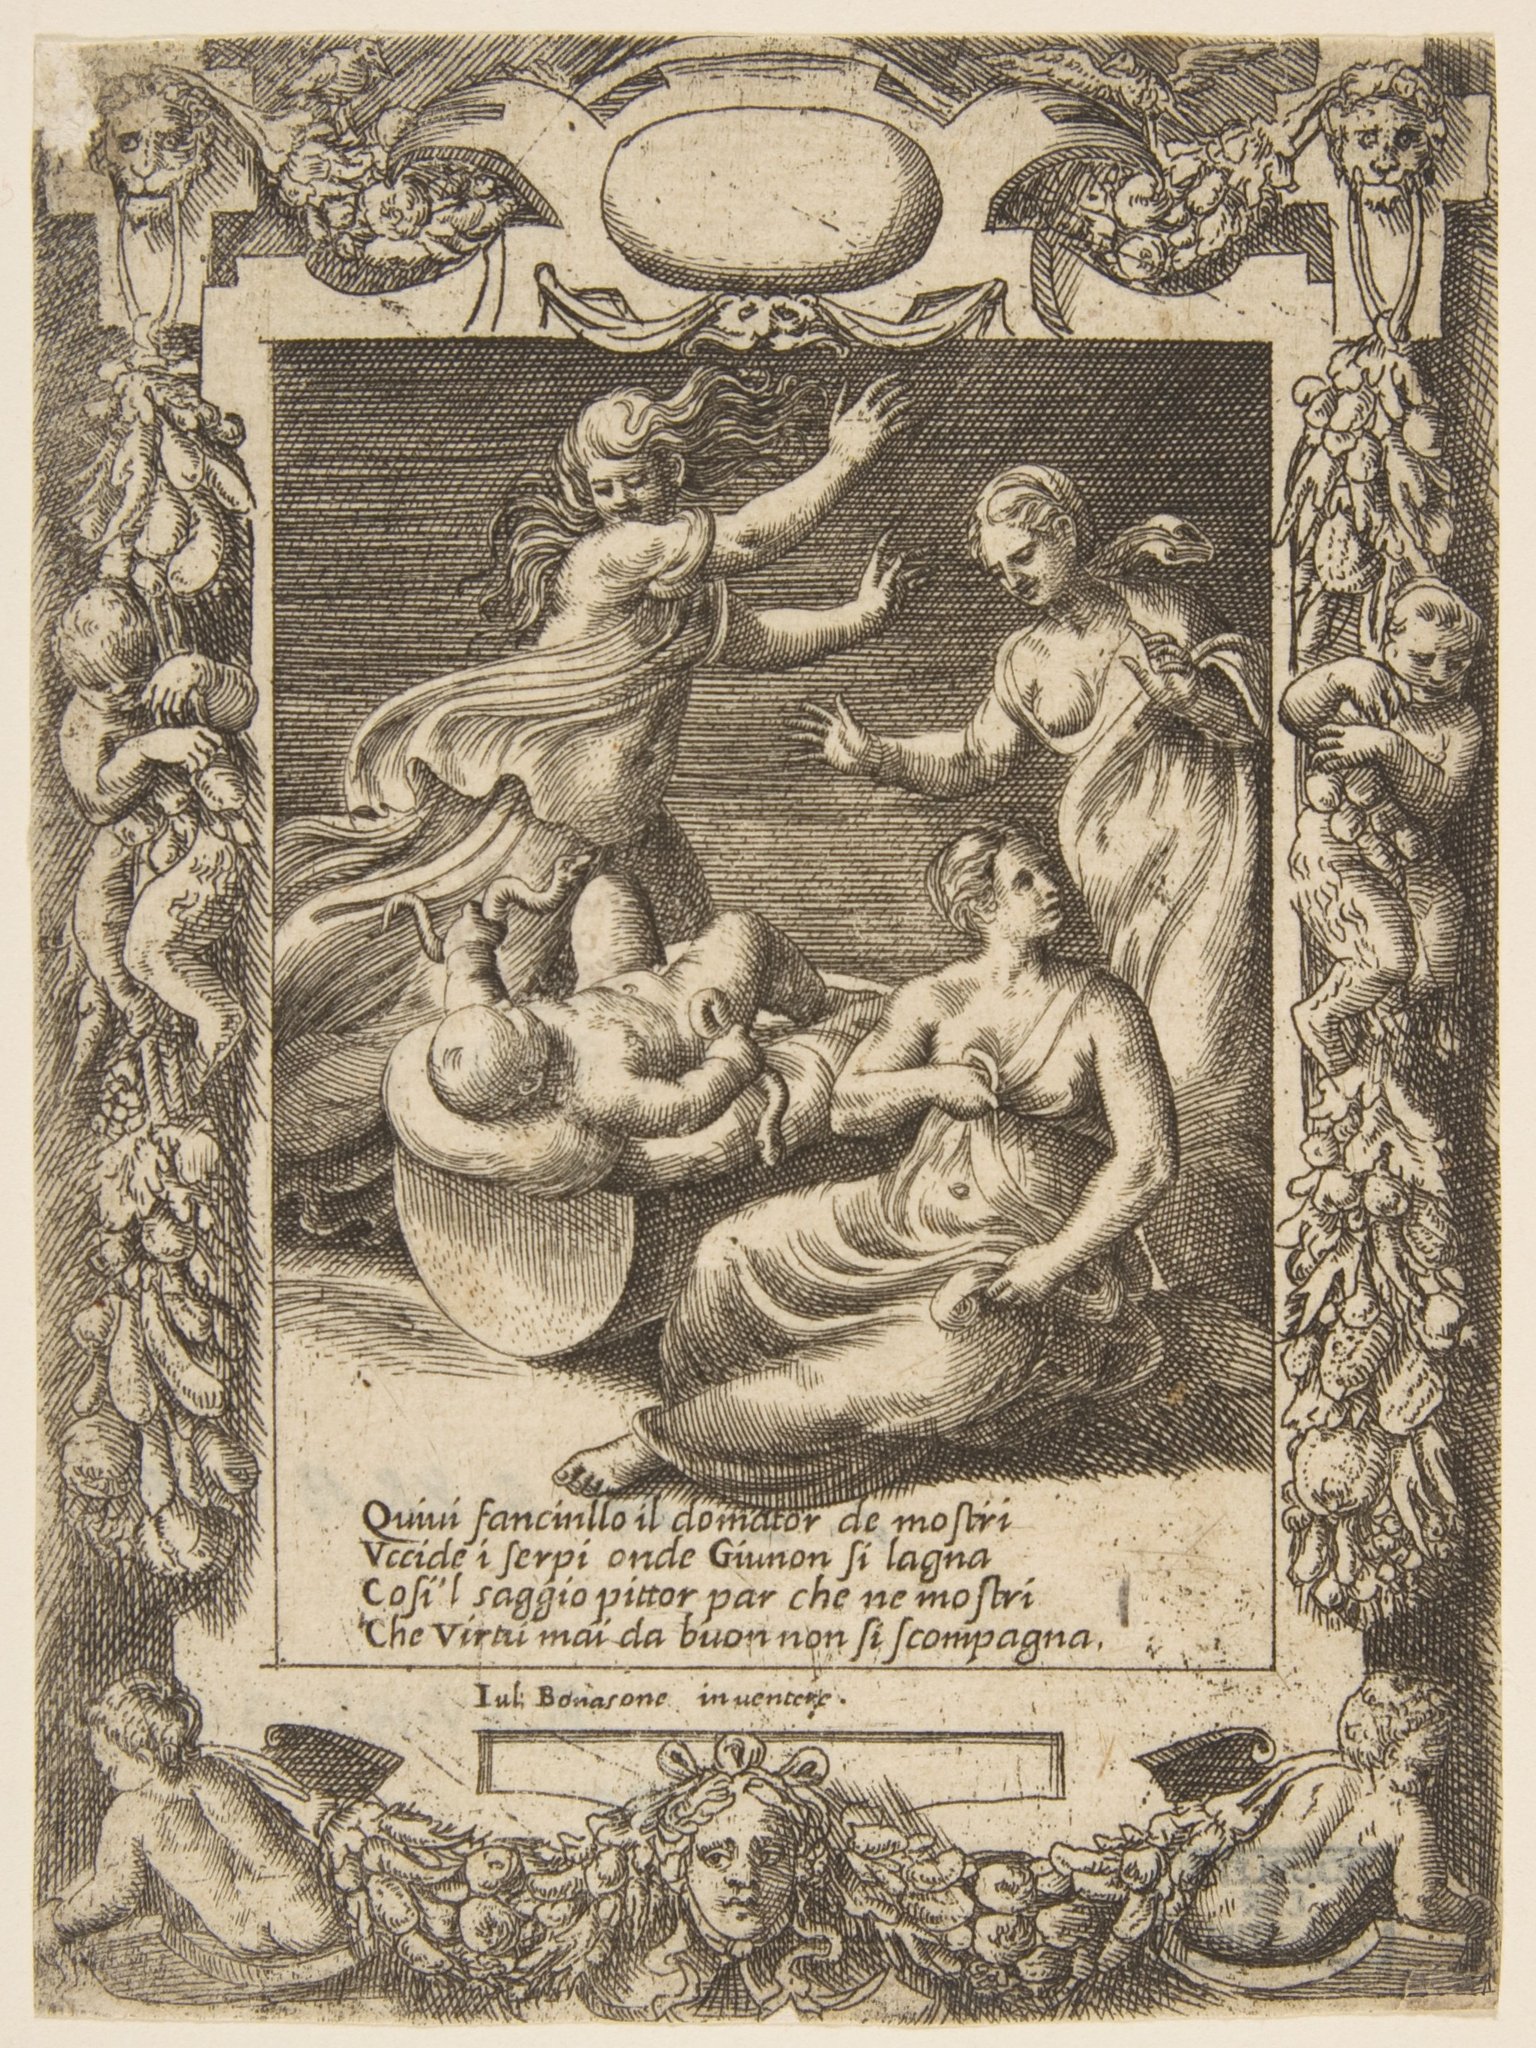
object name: print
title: The infant Hercules killing the snakes, set within an elaborate frame, from "Loves, Rages and Jealousies of Juno"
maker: giulio bonasone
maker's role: artist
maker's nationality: italian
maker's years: 1510-1576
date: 1531-1576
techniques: engraving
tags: hercules,juno,snakes